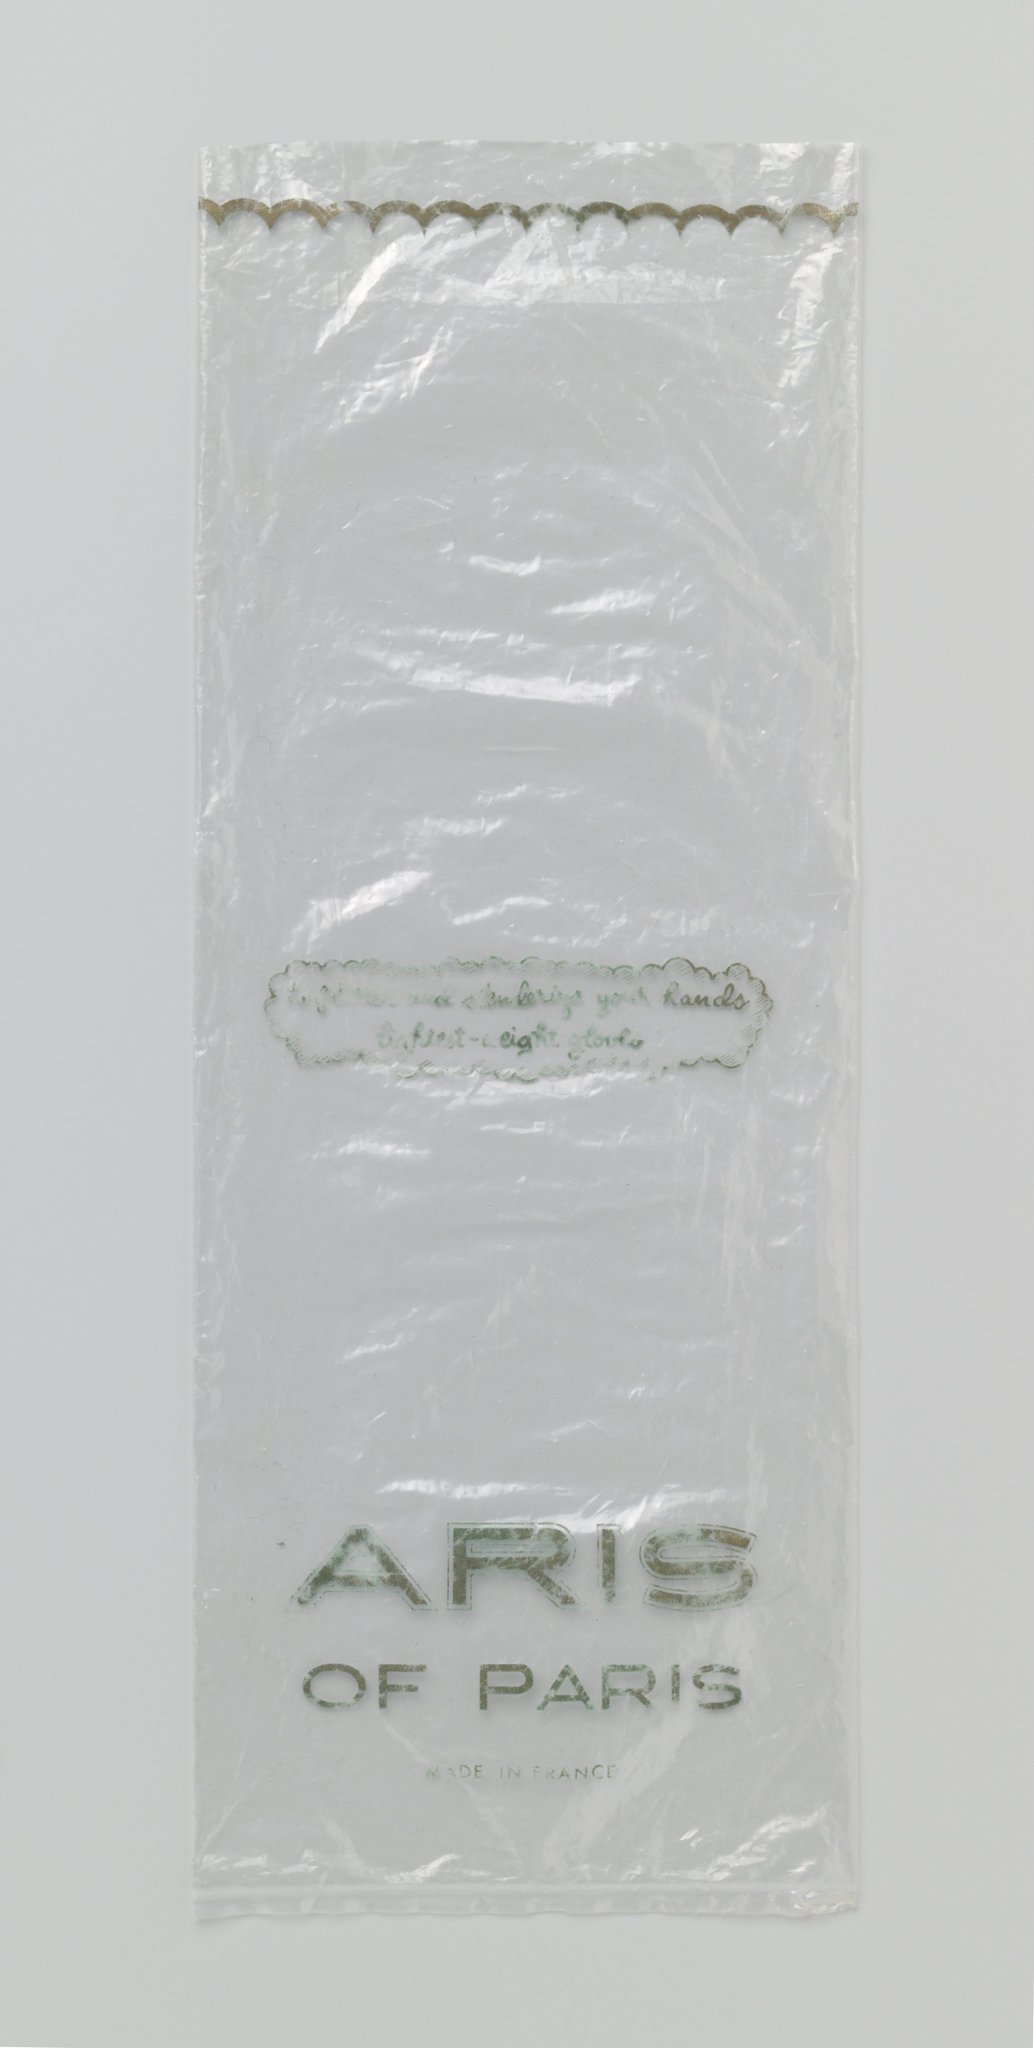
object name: packing material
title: Verpakking aris handschoen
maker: Anonymous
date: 1950-1970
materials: plastic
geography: france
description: Doorzichtige plastic handschoen verpakking met groene letters